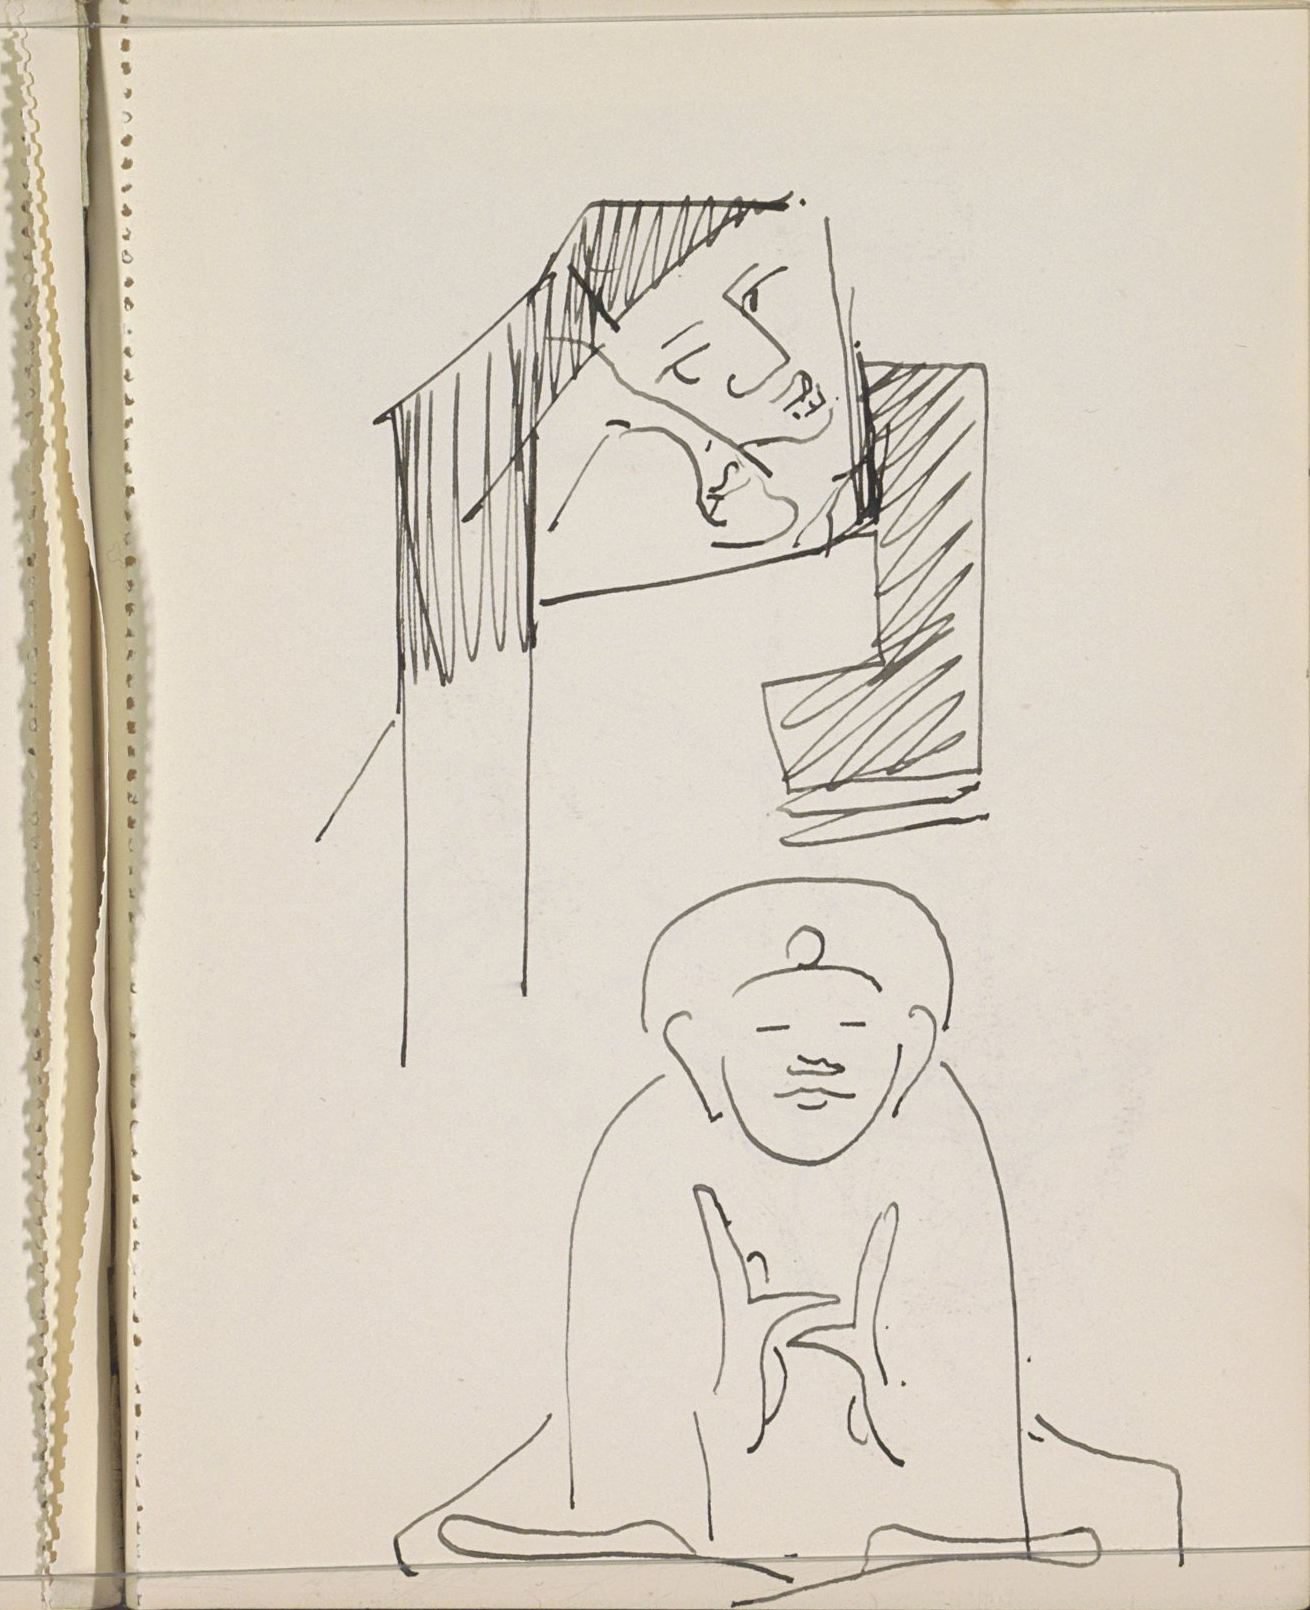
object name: sketchbook leaf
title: Twee geabstraheerde gezichten en een man in kleermakerszit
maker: reijer stolk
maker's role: draughtsman, print maker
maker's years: 1896-1945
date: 1906-1945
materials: paper, pencil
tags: face, sitting cross-legged, as tailor at work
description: Blad 33 recto uit een schetsboek met 42 bladen.